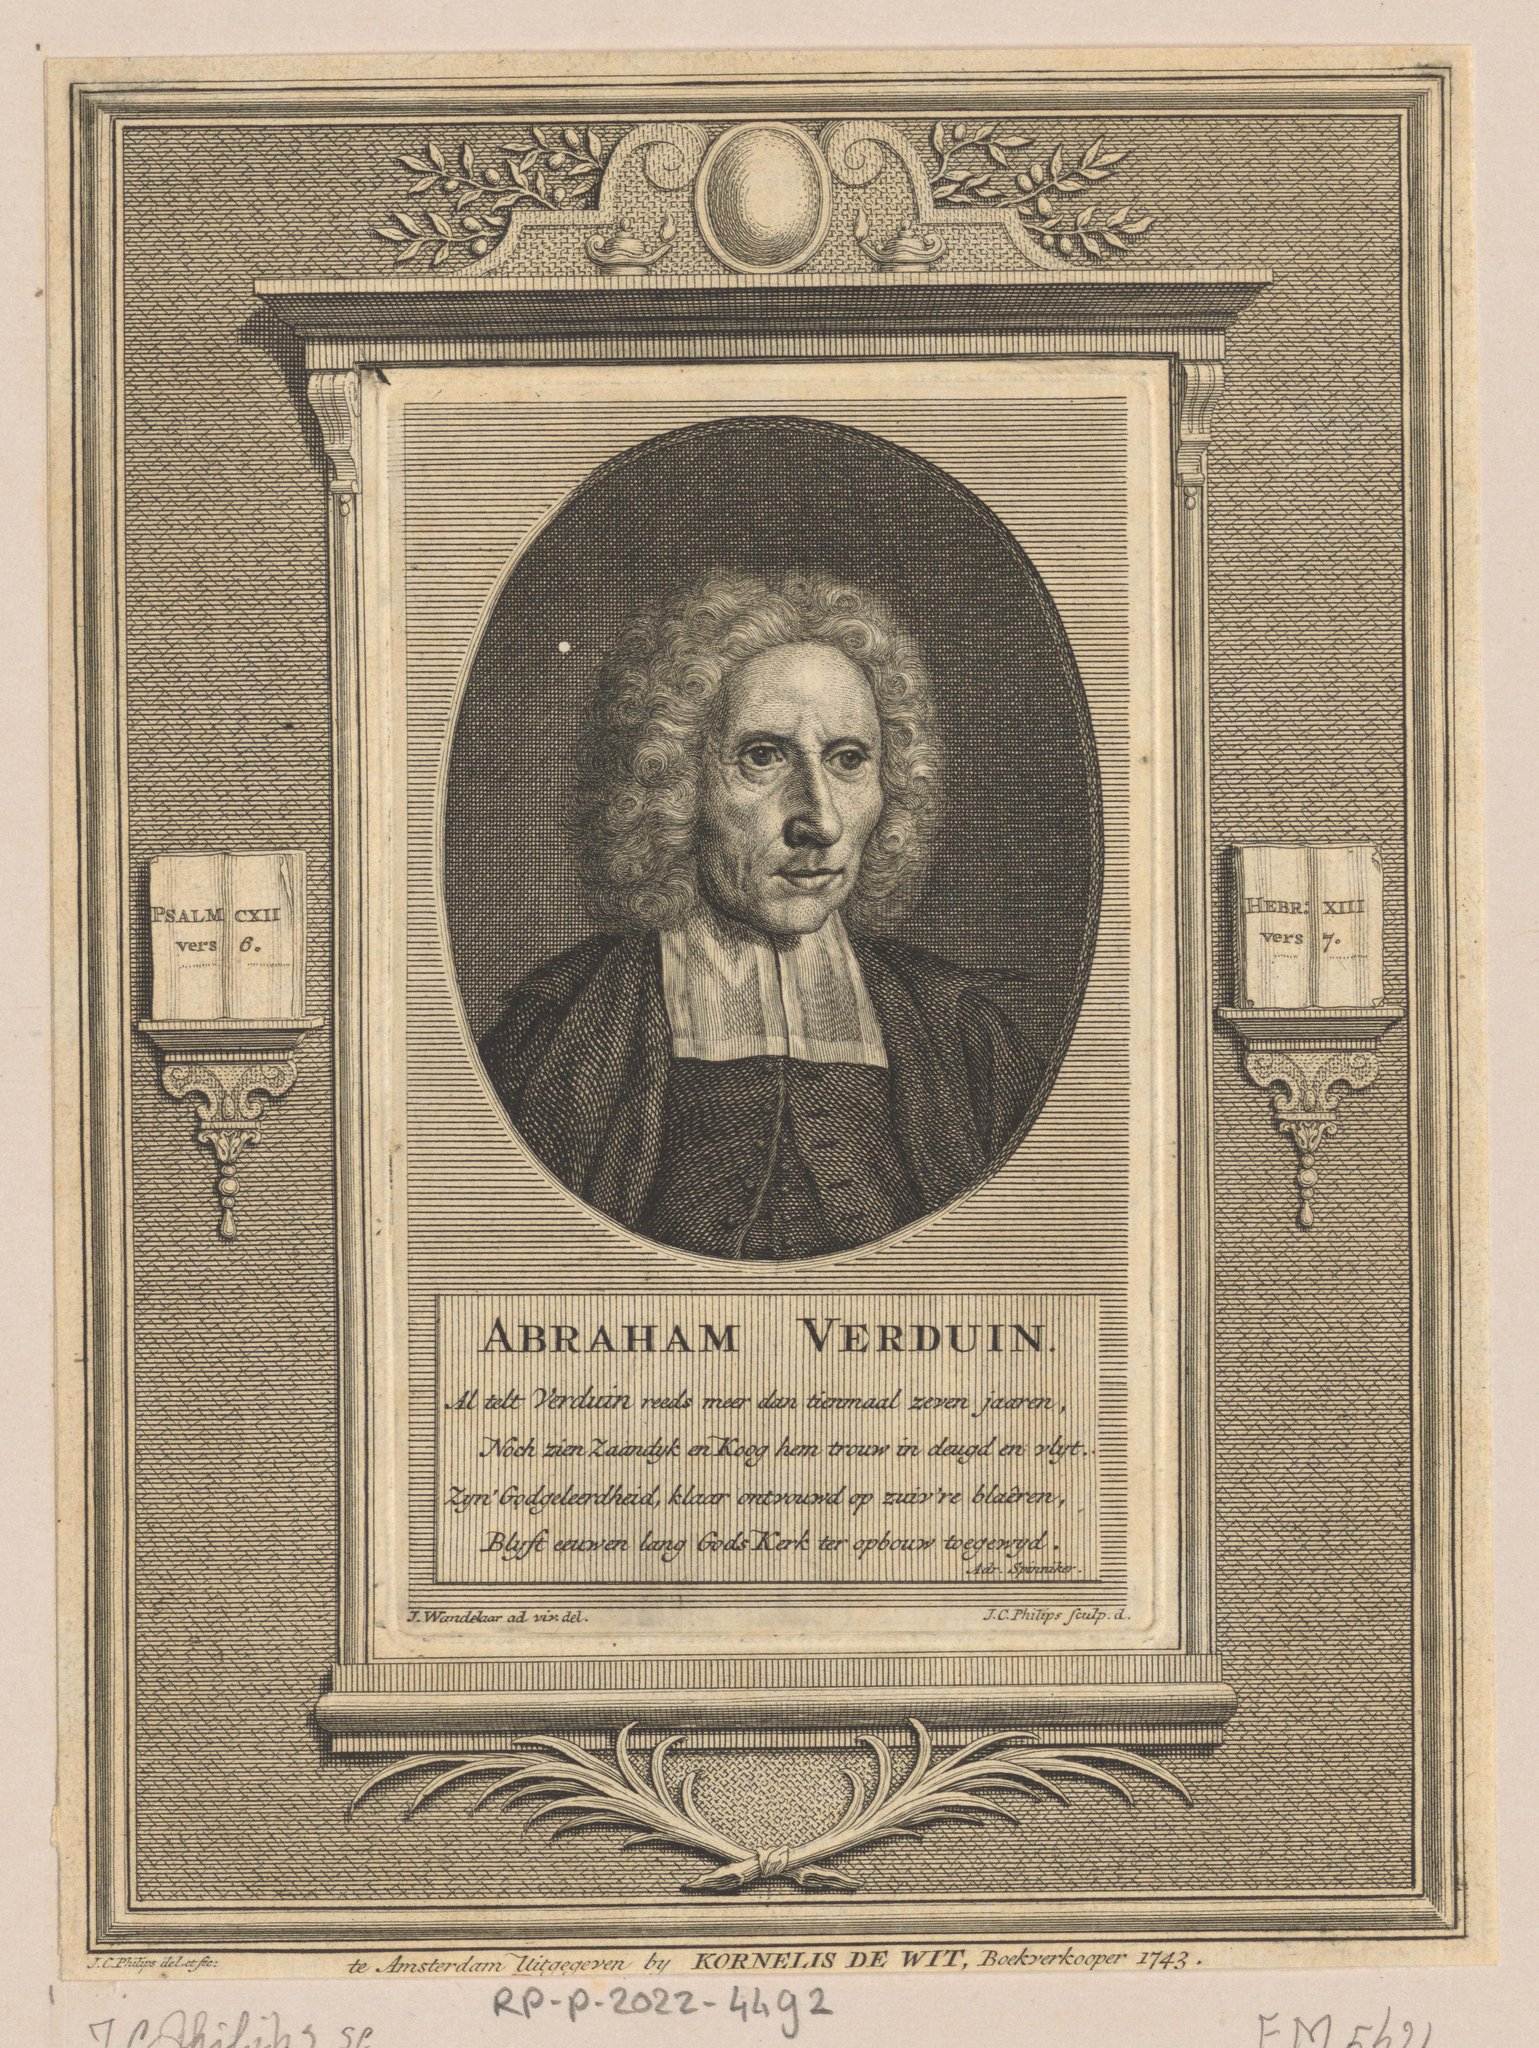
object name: print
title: Portret van Abraham Verduin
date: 1743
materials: paper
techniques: engraving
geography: amsterdam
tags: koog aan de zaan, theologian, historical persons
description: Prent waarschijnlijk uit: Verzaameling van de afbeeldingen van veele voornaame mannen en leeraaren, die (...) het leeraars ampt onder de doopsgezinde christenen bediend hebben. Amsterdam: Kornelis de Wit, 1743.